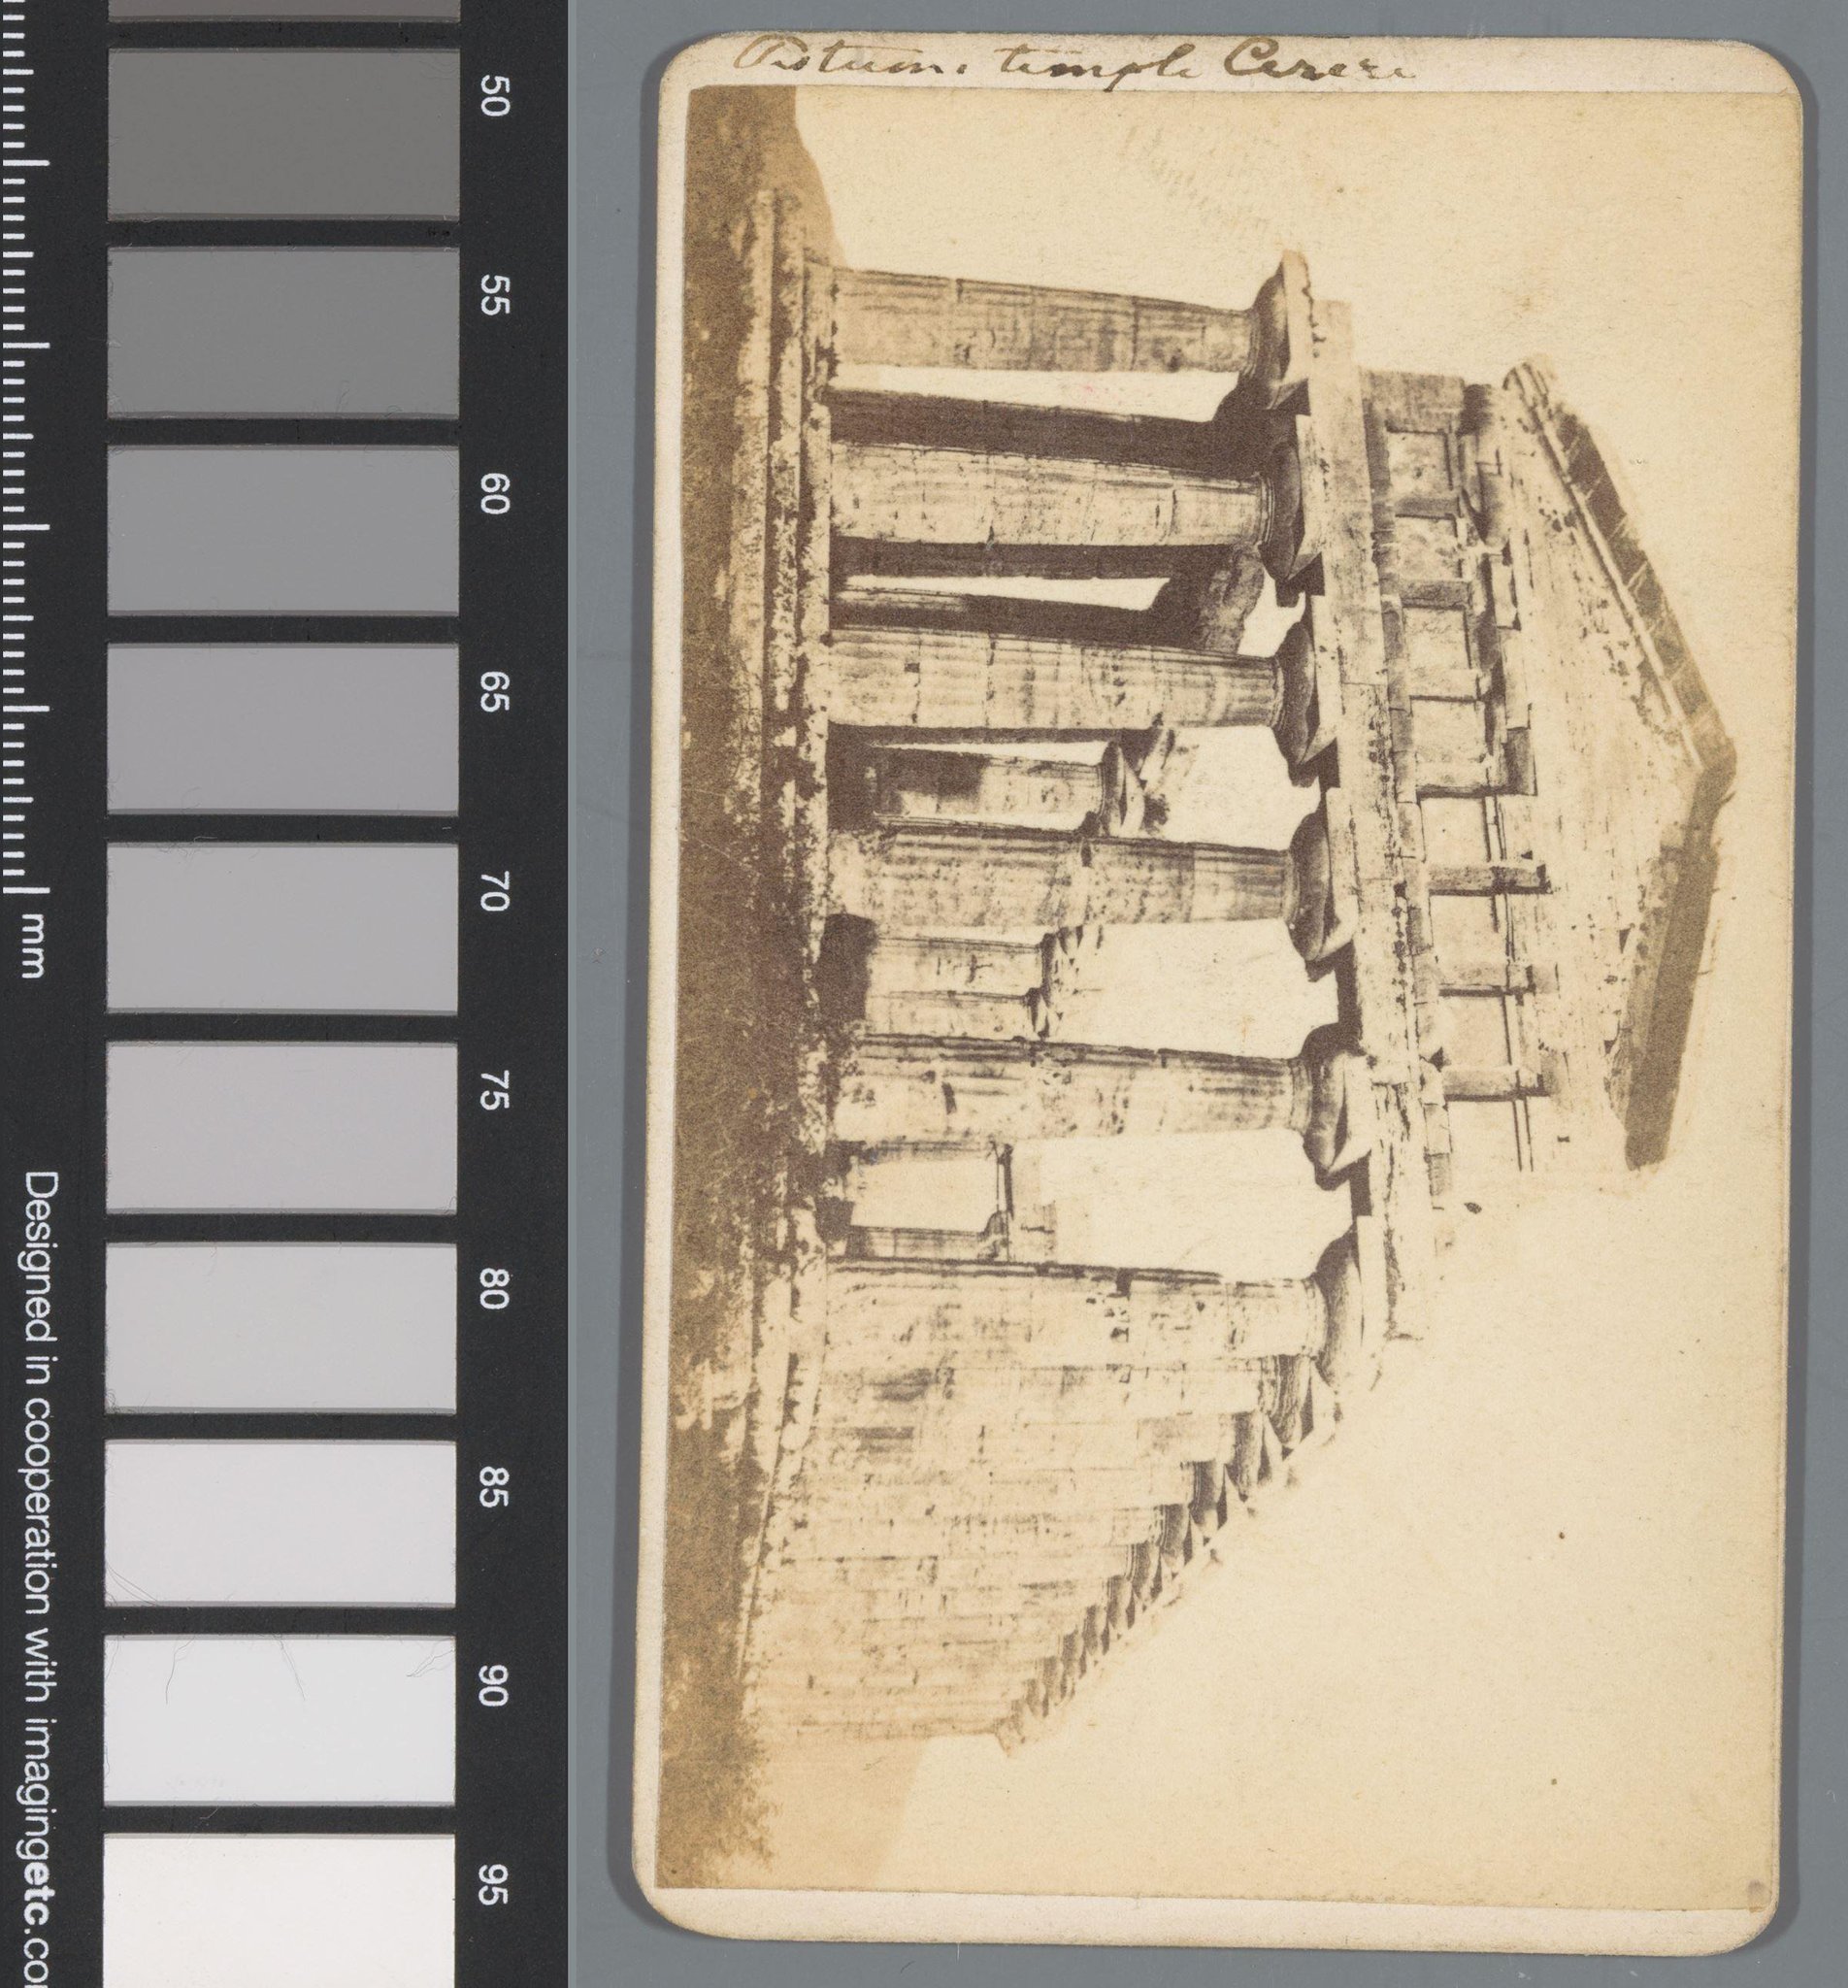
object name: photograph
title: Tempel van Athena in Paestum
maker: Anonymous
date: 1855-1885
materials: cardboard, paper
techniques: albumen print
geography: paestum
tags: temple, shrine ~ greek religion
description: Men heeft lange tijd ten onrechte aangenomen dat dit de Tempel van Ceres is geweest.